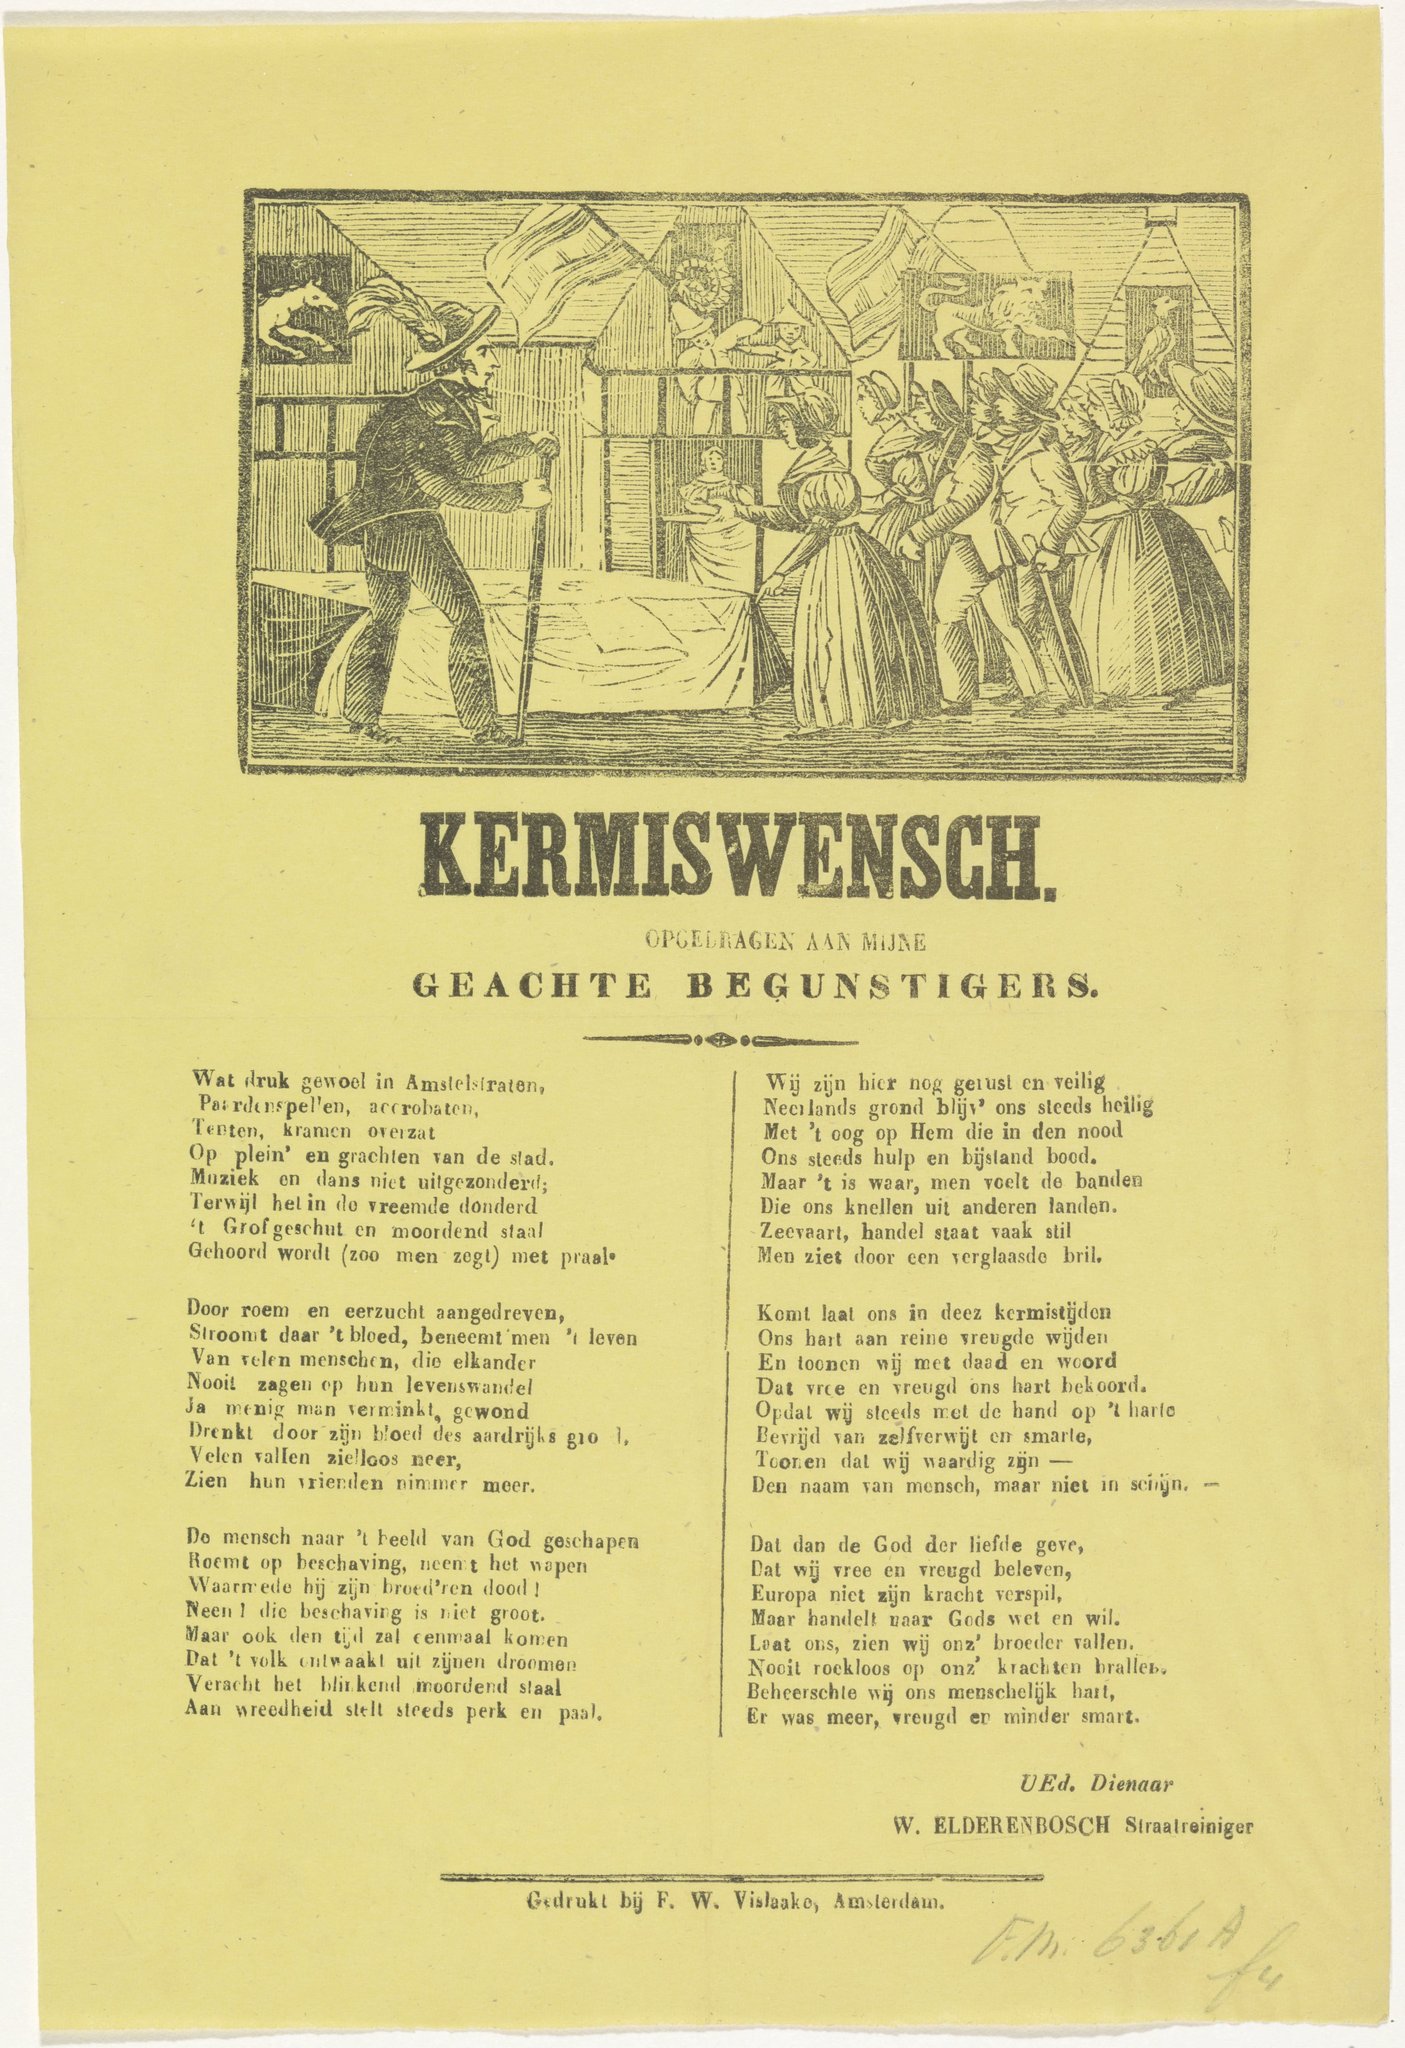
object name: print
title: Kermisprent van de Amsterdamse straatvegers, ca. 1860-1870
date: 1860-1870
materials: paper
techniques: letterpress printing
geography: amsterdam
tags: pleasure fair and circus, amsterdam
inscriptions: collector's mark: Lugt 2228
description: Kermisprent van de Amsterdamse straatvegers, ca. 1860-1870. Gezicht op de Amsterdamse kermis. Met een vers in twee kolommen. Namens de straatveger: W. Elderenbosch.